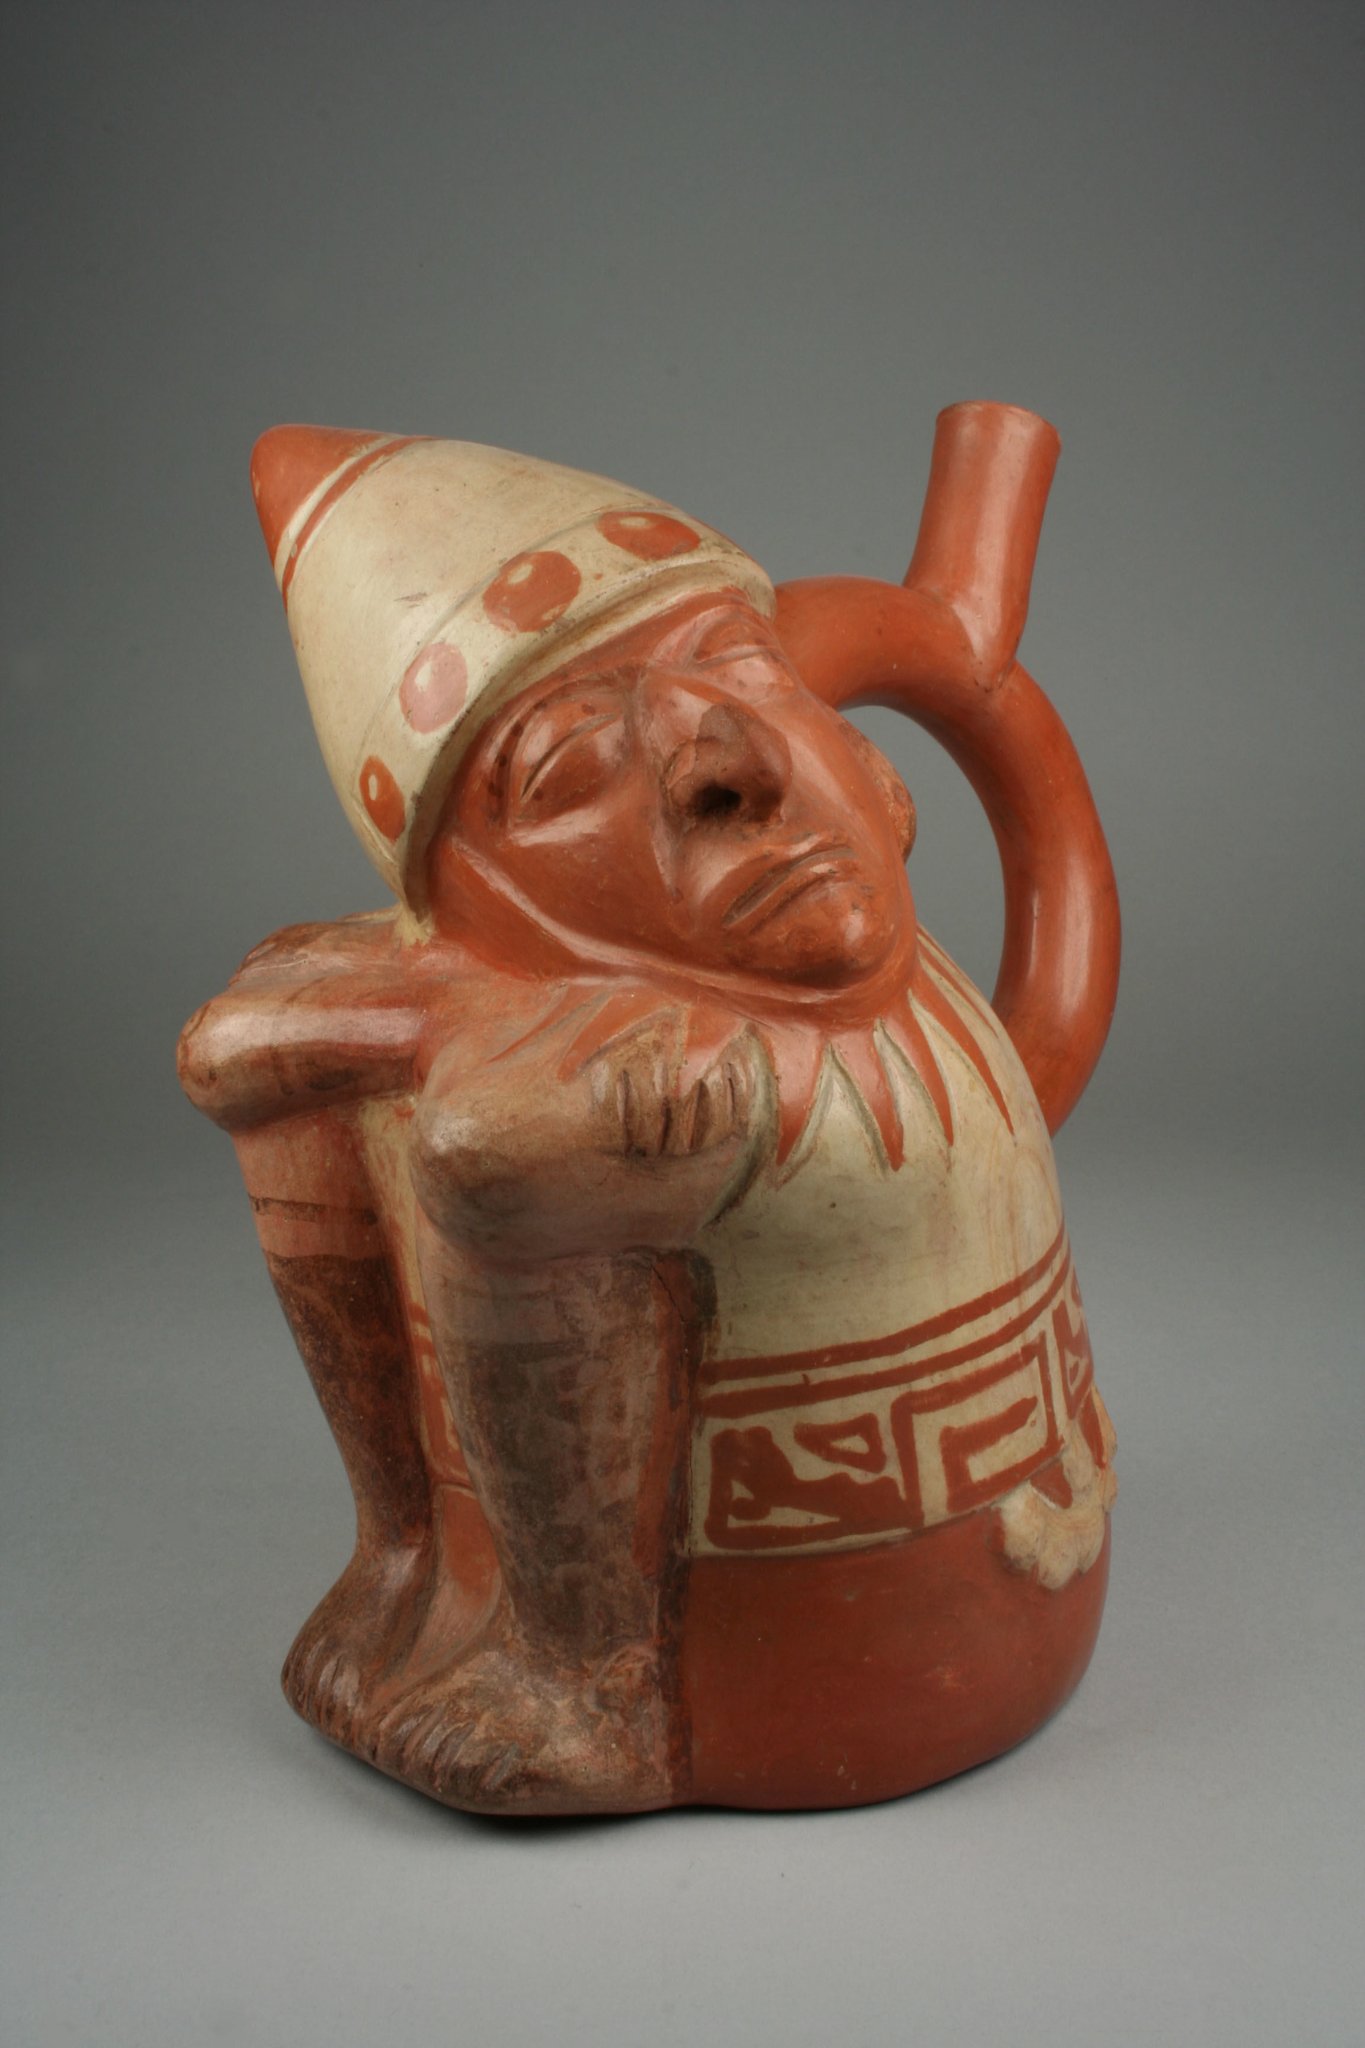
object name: bottle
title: Stirrup Spout Bottle with Sleeping Warrior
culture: moche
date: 1-400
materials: ceramic, pigment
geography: peru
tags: sleeping,warriors